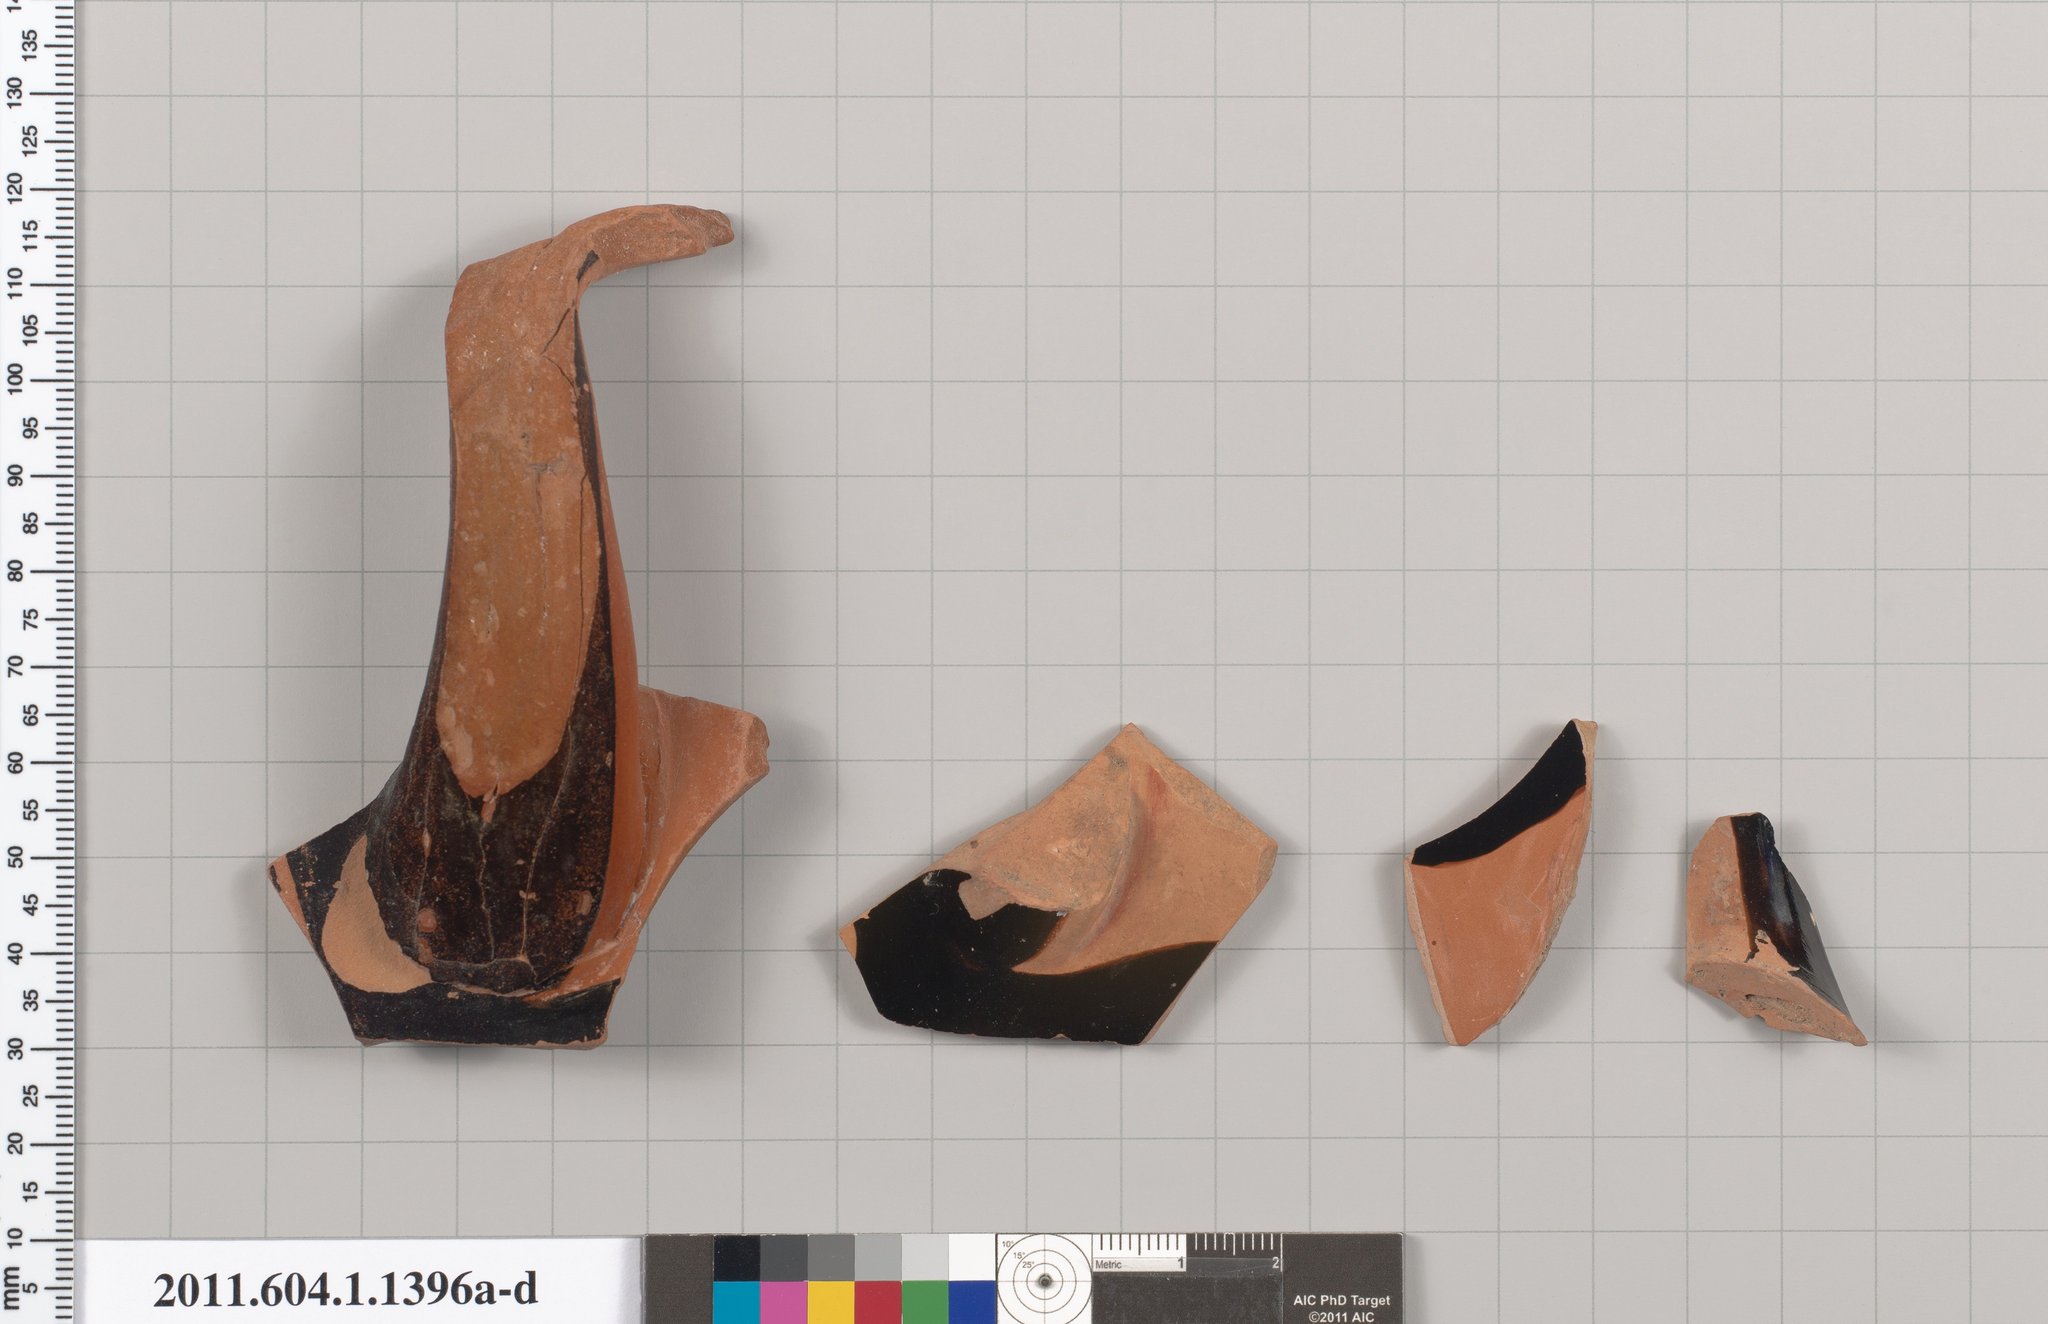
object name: kylix fragment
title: Terracotta fragments of kylikes (drinking cups)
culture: greek, attic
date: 500-401 BCE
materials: terracotta